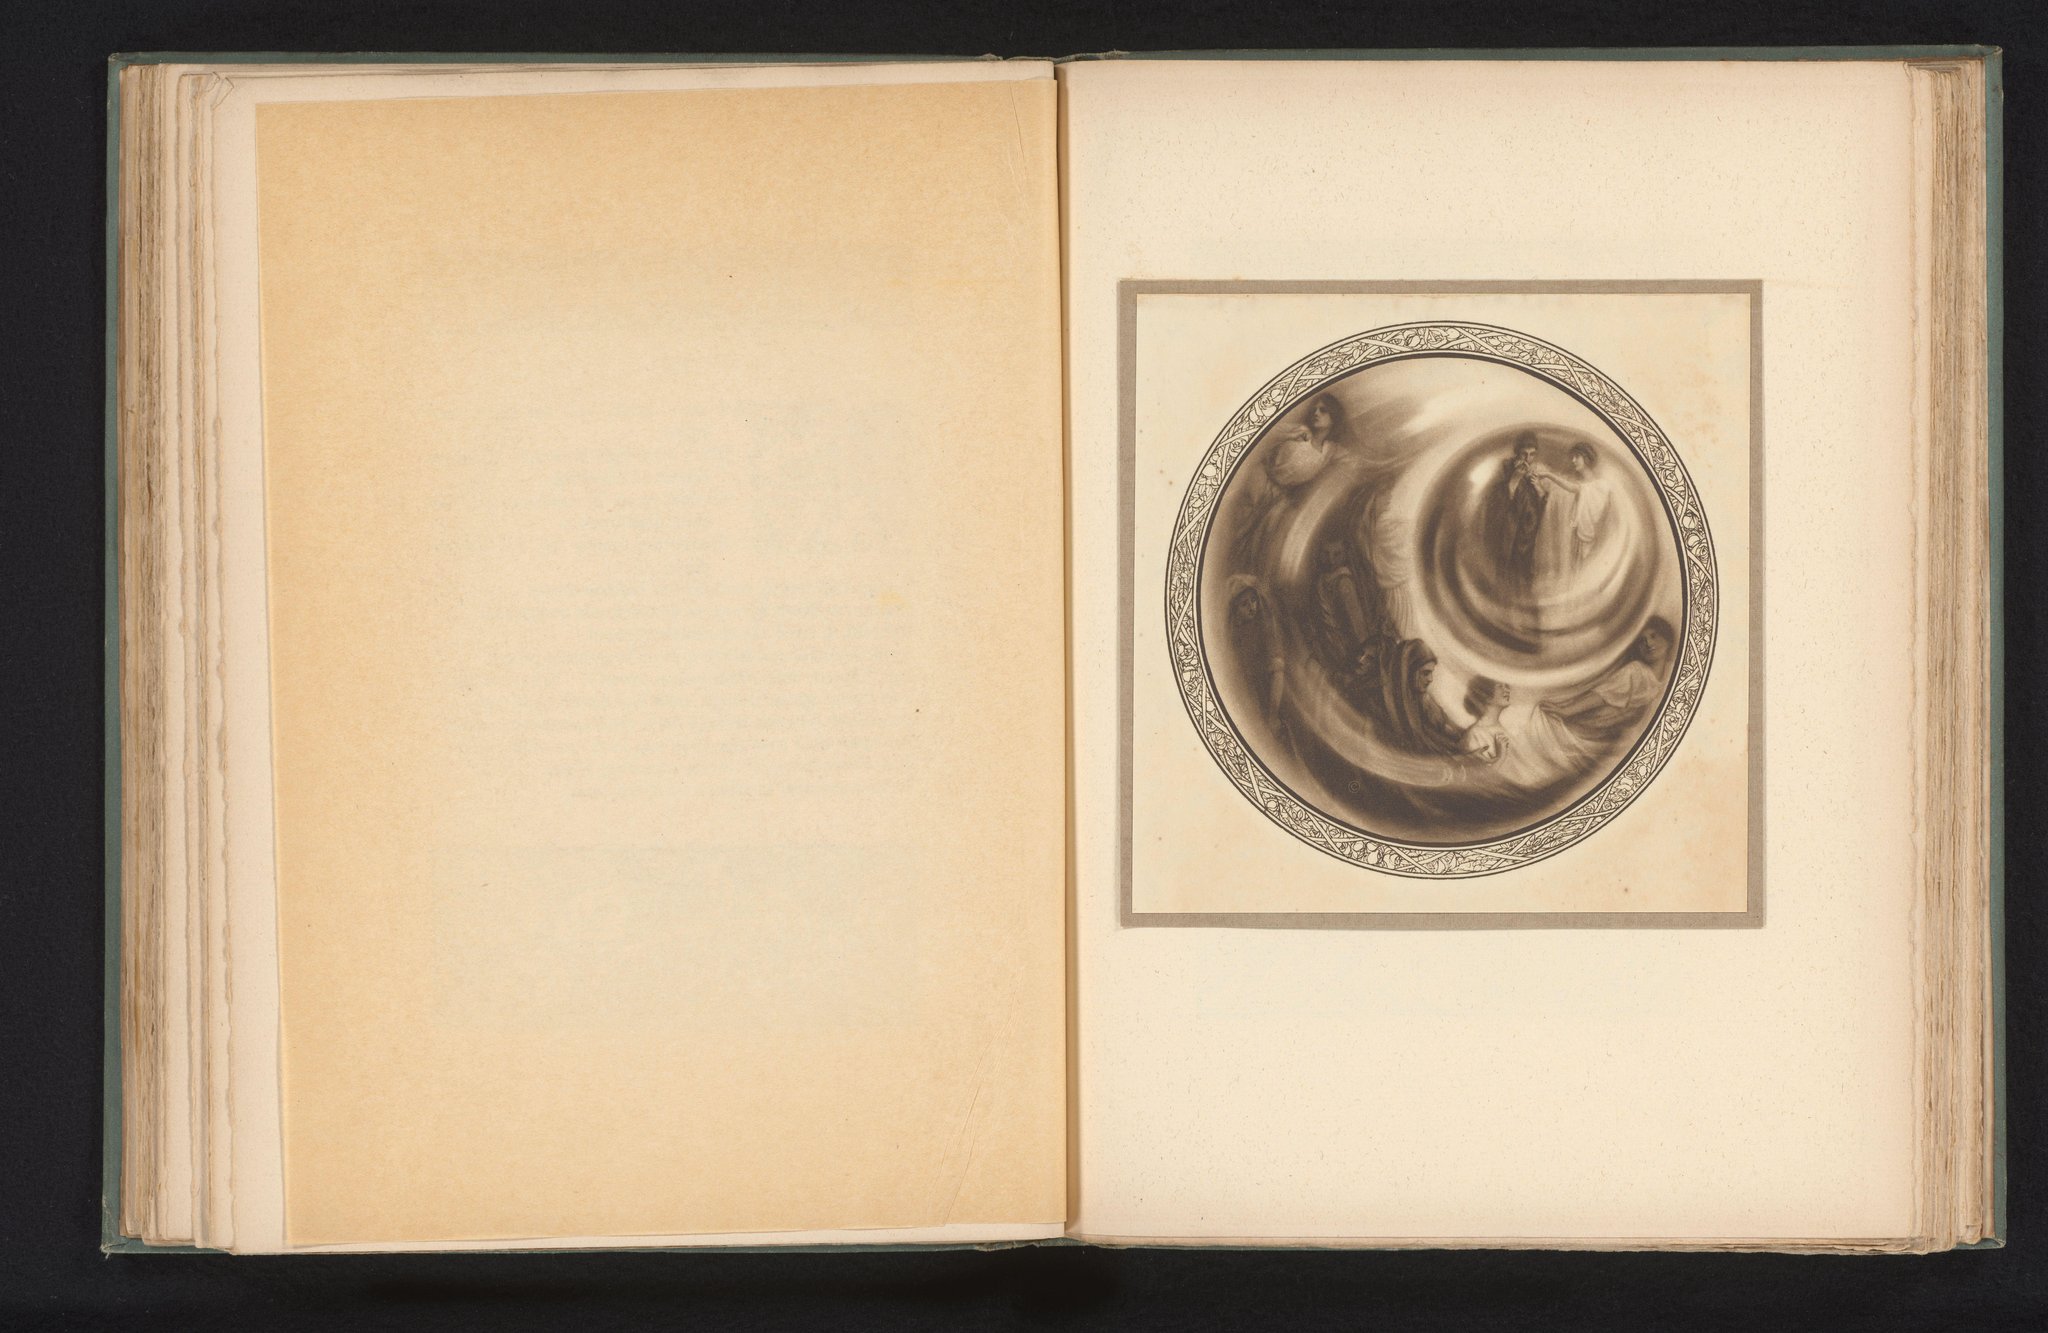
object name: page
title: Mensen in een maalstroom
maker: adelaide hanscom leeson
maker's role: painter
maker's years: 1875-1931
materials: cardboard, paper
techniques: photoaquatint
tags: whirlpool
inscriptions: copyright notice: ‘C’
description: Prent op ongenummerde pagina. Adelaide Hanscom Leeson manipuleerde haar glasnegatieven om een schilderachtig efffect te bewerkstelligen.